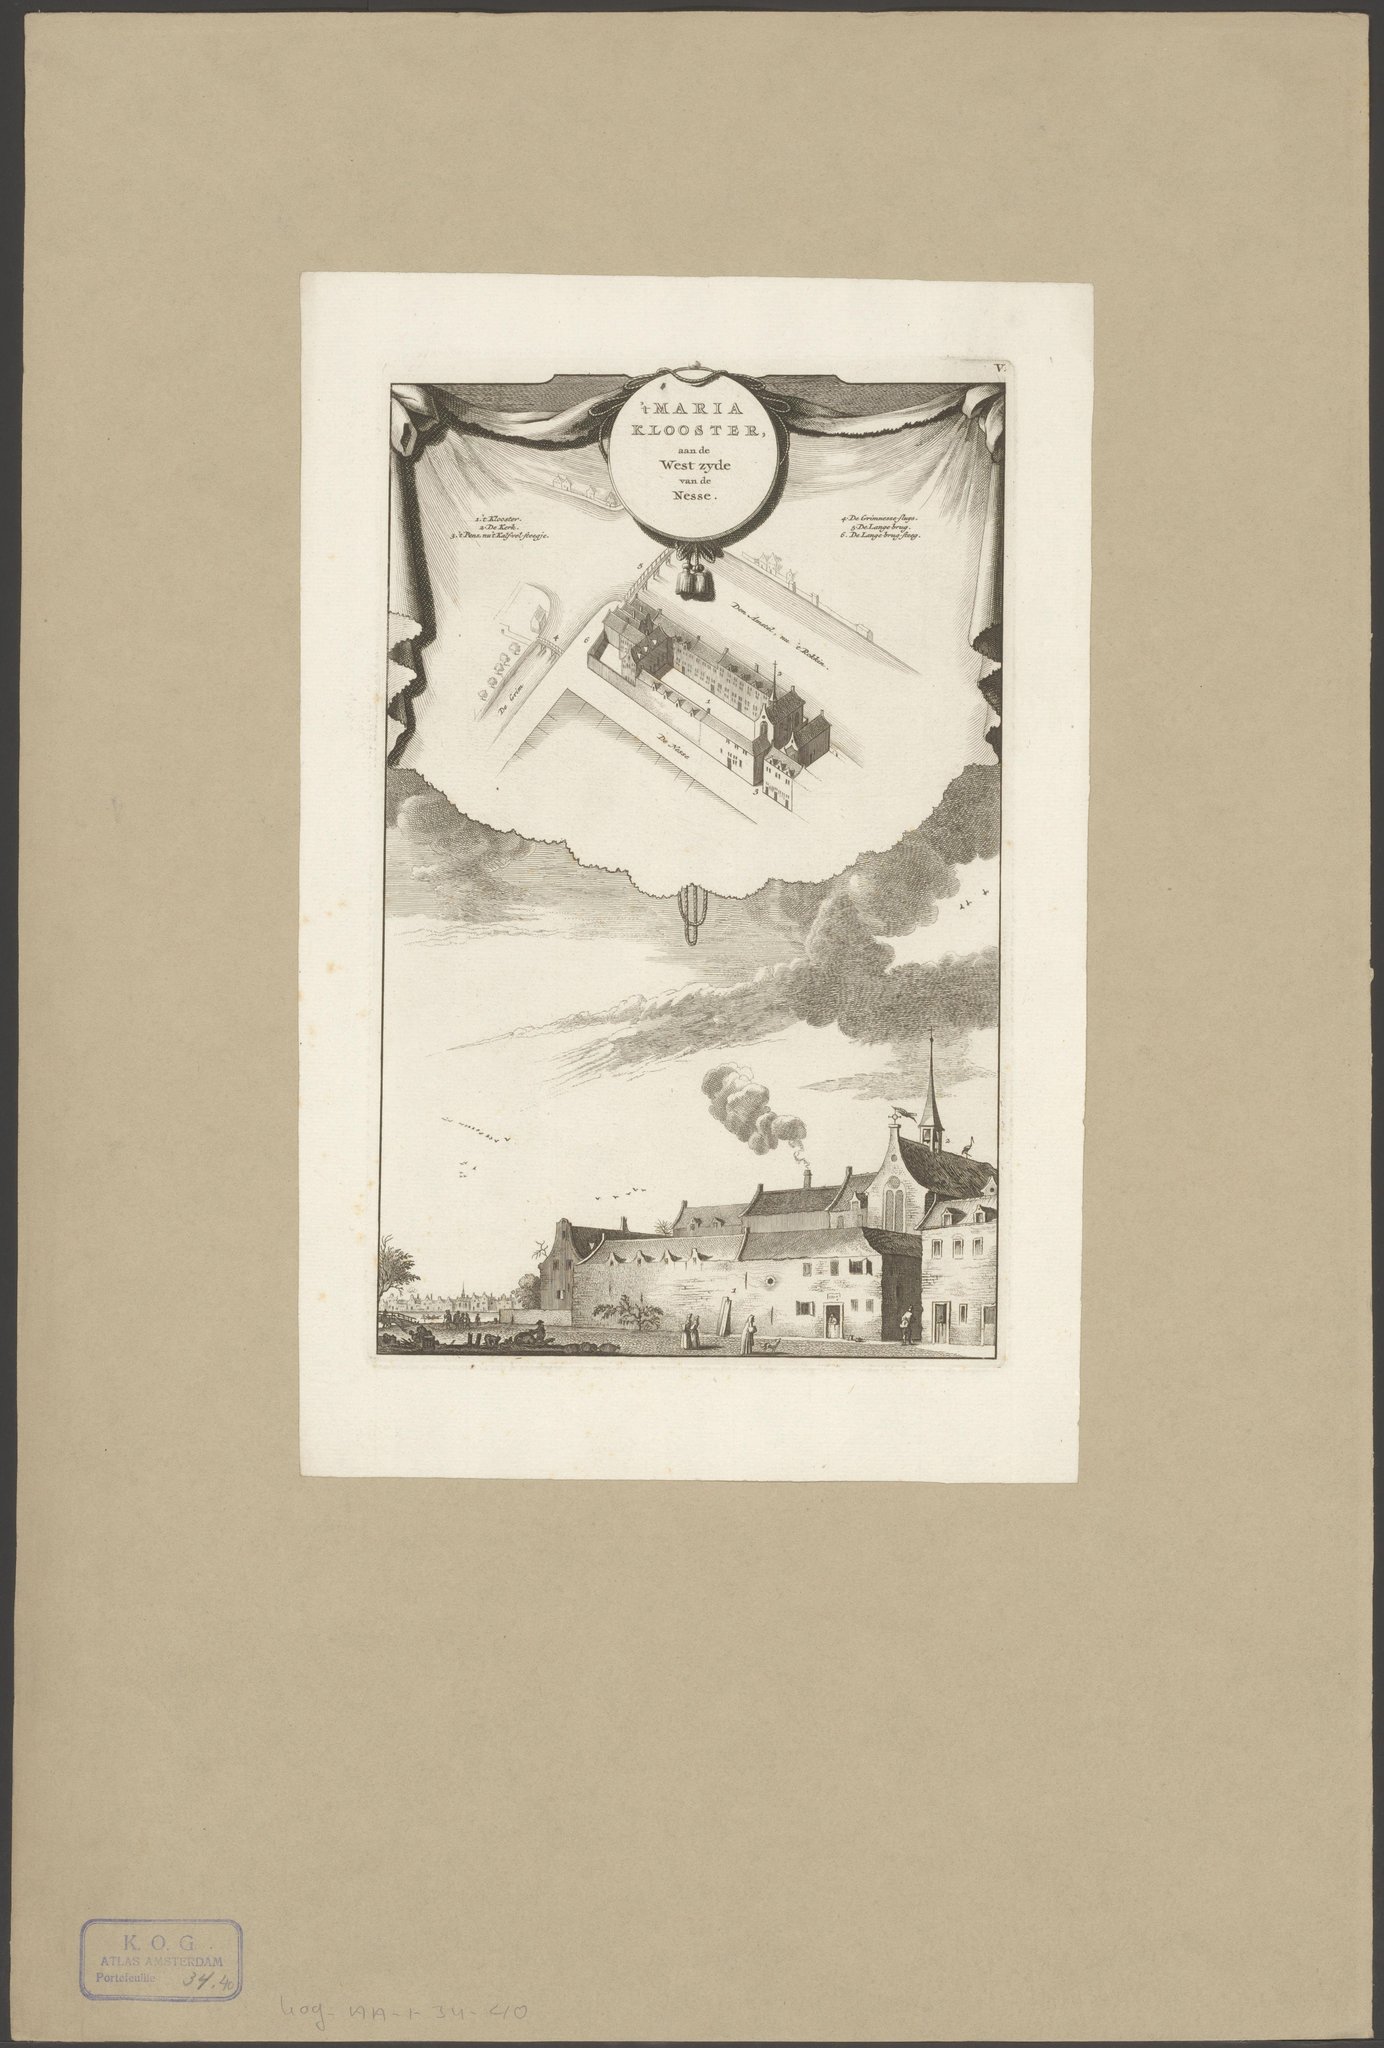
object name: print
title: 't Maria Klooster, aan de West zyde van de Nesse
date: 1760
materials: paper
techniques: engraving, etching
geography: amsterdam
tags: abbey, monastery, convent ~ roman catholic church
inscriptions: collector's mark: Lugt 1641b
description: Prent mogelijk uit: Wagenaar, Jan. Amsterdam, in zyne opkomst, aanwas, geschiedenissen (…). Amsterdam: Isaak Tirion, 1760, dl. 1. Dat de prent de situatie rond 1544 weergeeft, gaat terug op het feit dat voor het maken van deze en andere prenten van kloosters en kerken van voor de Alteratie (1578) is uitgegaan van de plattegrond van Cornelis Anthonisz. uit 1544, zie RP-P-OB-70.399 en RP-P-AO-20-15.